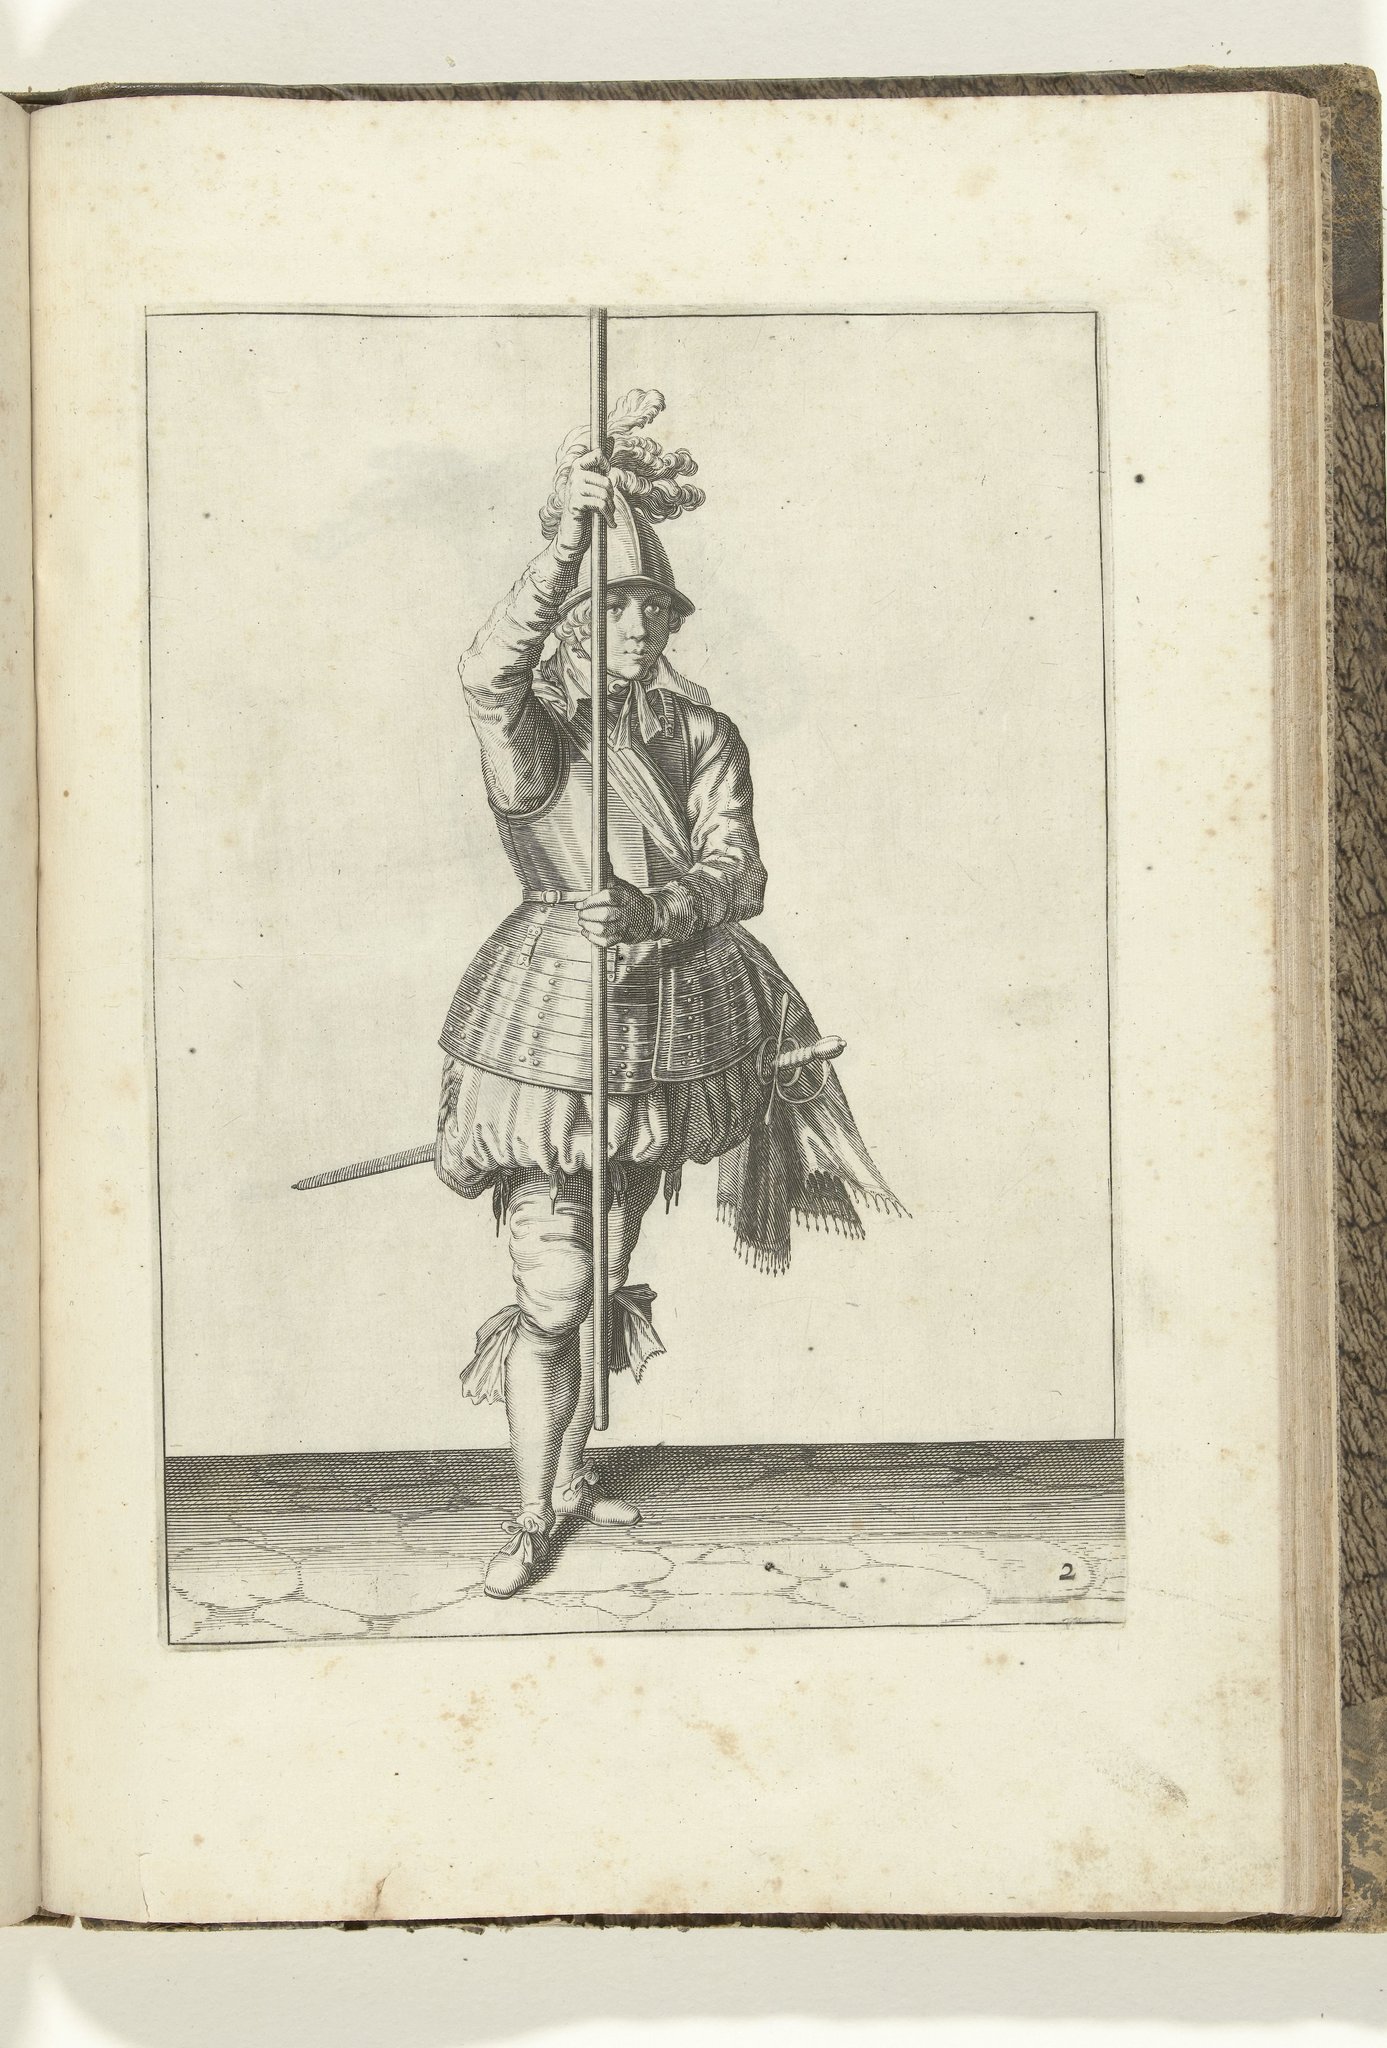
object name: print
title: Soldaat, van voren gezien, die zijn spies met beide handen rechtop voor zich iets boven de grond vasthoudt (nr. 2), ca. 1600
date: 1597-1608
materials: paper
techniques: engraving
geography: northern netherlands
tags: the hague, maurice (prince of orange), handling of weapons ~ military training, weapons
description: Een soldaat, ten voeten uit, die een spies (lans) met beide handen rechtop voor zich iets boven de grond vasthoudt (nr. 2), ca. 1600. Dit is de eerste handeling voor het rechtop opheffen van de spies. Plaat 2 in de instructies voor het hanteren van de spies: Enseignement brief; et succint sur les portraitz figurez, touchant l'usage, de tout ce qu'un Soldat doibt faire au maniement de la Pique. Onderdeel van de illustraties in een Franse editie van J. de Gheyns Wapenhandelinghe: J. de Gheyn, Maniement d'armes, d'arquebuses, mousquetz et piques : en conformité de l'ordre de Mour le Prince Maurice, Prince d'Orange, Amsterdam 1608. Krijgswezen rond 1600.